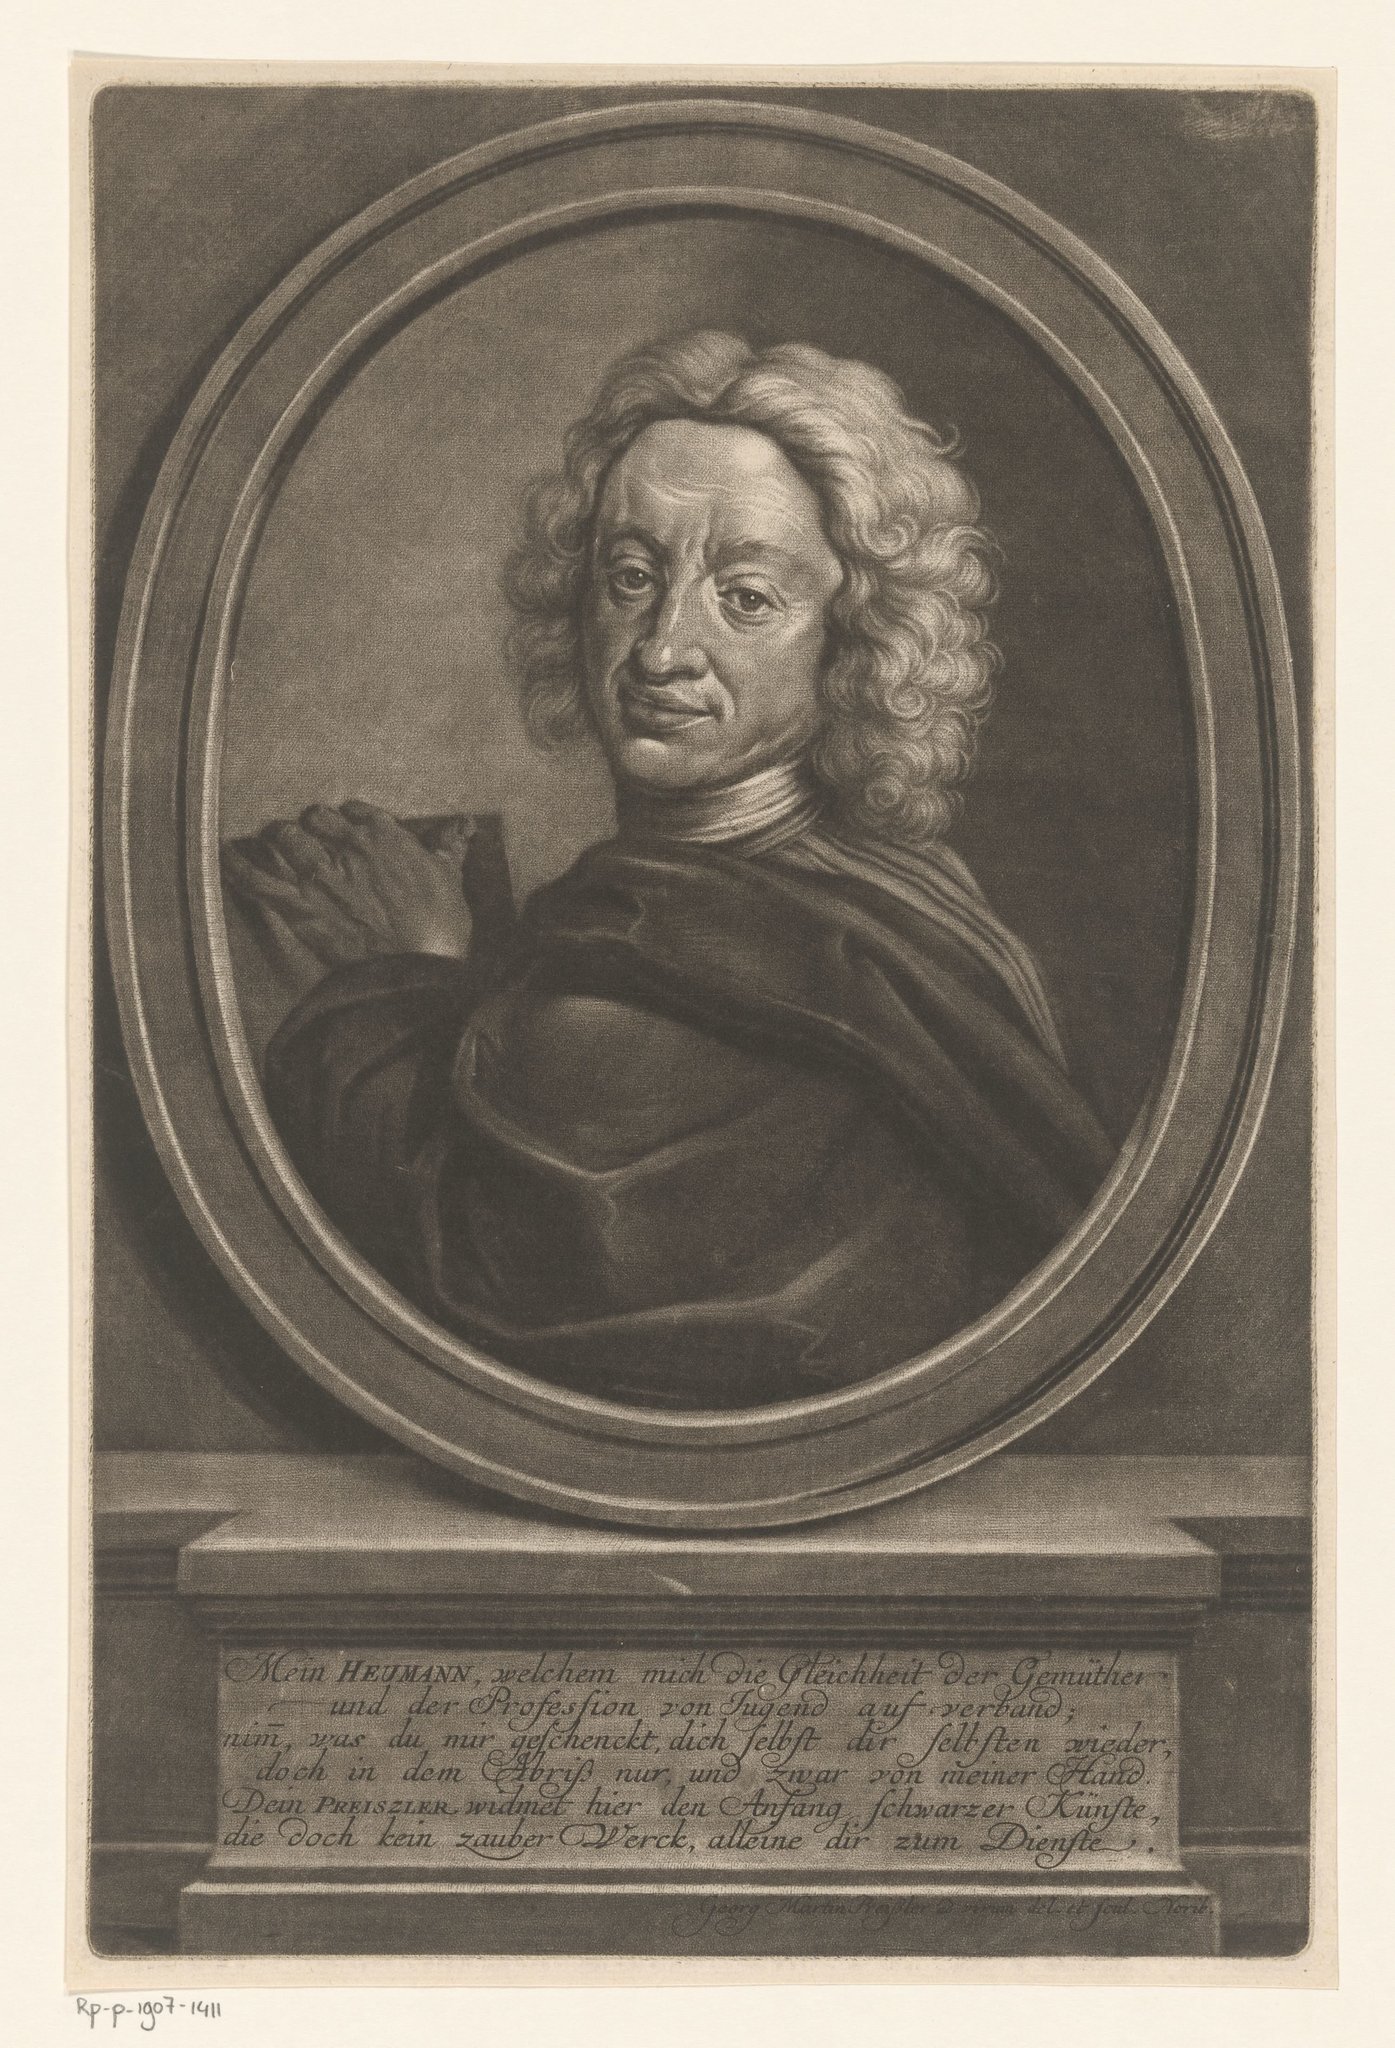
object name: print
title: Portret van Georg Daniel Heumann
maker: georg martin preissler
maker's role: print maker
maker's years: 1700-1754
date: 1710-1754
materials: paper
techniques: mezzotint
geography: nuremberg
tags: print maker, draughtsman, historical persons, portrait, self-portrait of graphic artist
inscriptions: collector's mark: Lugt 2228